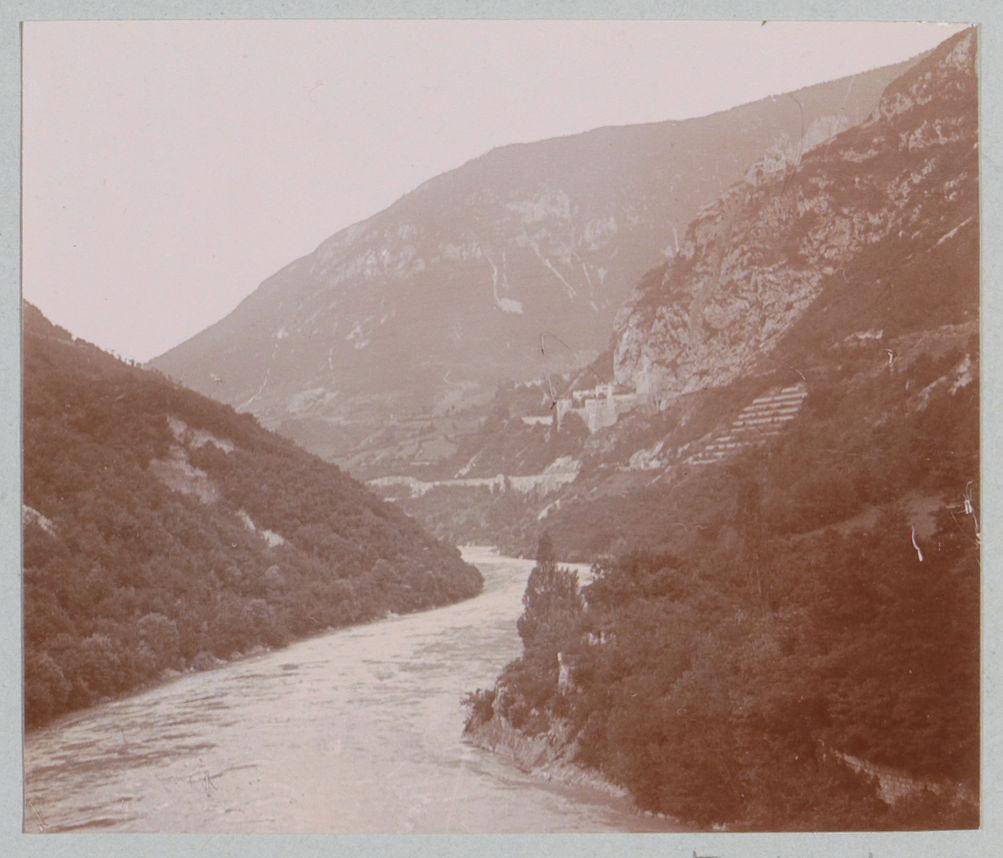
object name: photograph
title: Gezicht op een rivierdal met op de achtergrond een fort, vermoedelijk in Frankrijk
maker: Anonymous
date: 1905-1910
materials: paper, photographic support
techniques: gelatin silver print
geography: france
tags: fortress, river (+ landscape with figures, staffage), france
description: Onderdeel van Fotoalbum van een Franse amateurfotograaf met bezienswaardigheden in Frankrijk, Zwitserland en Italië.